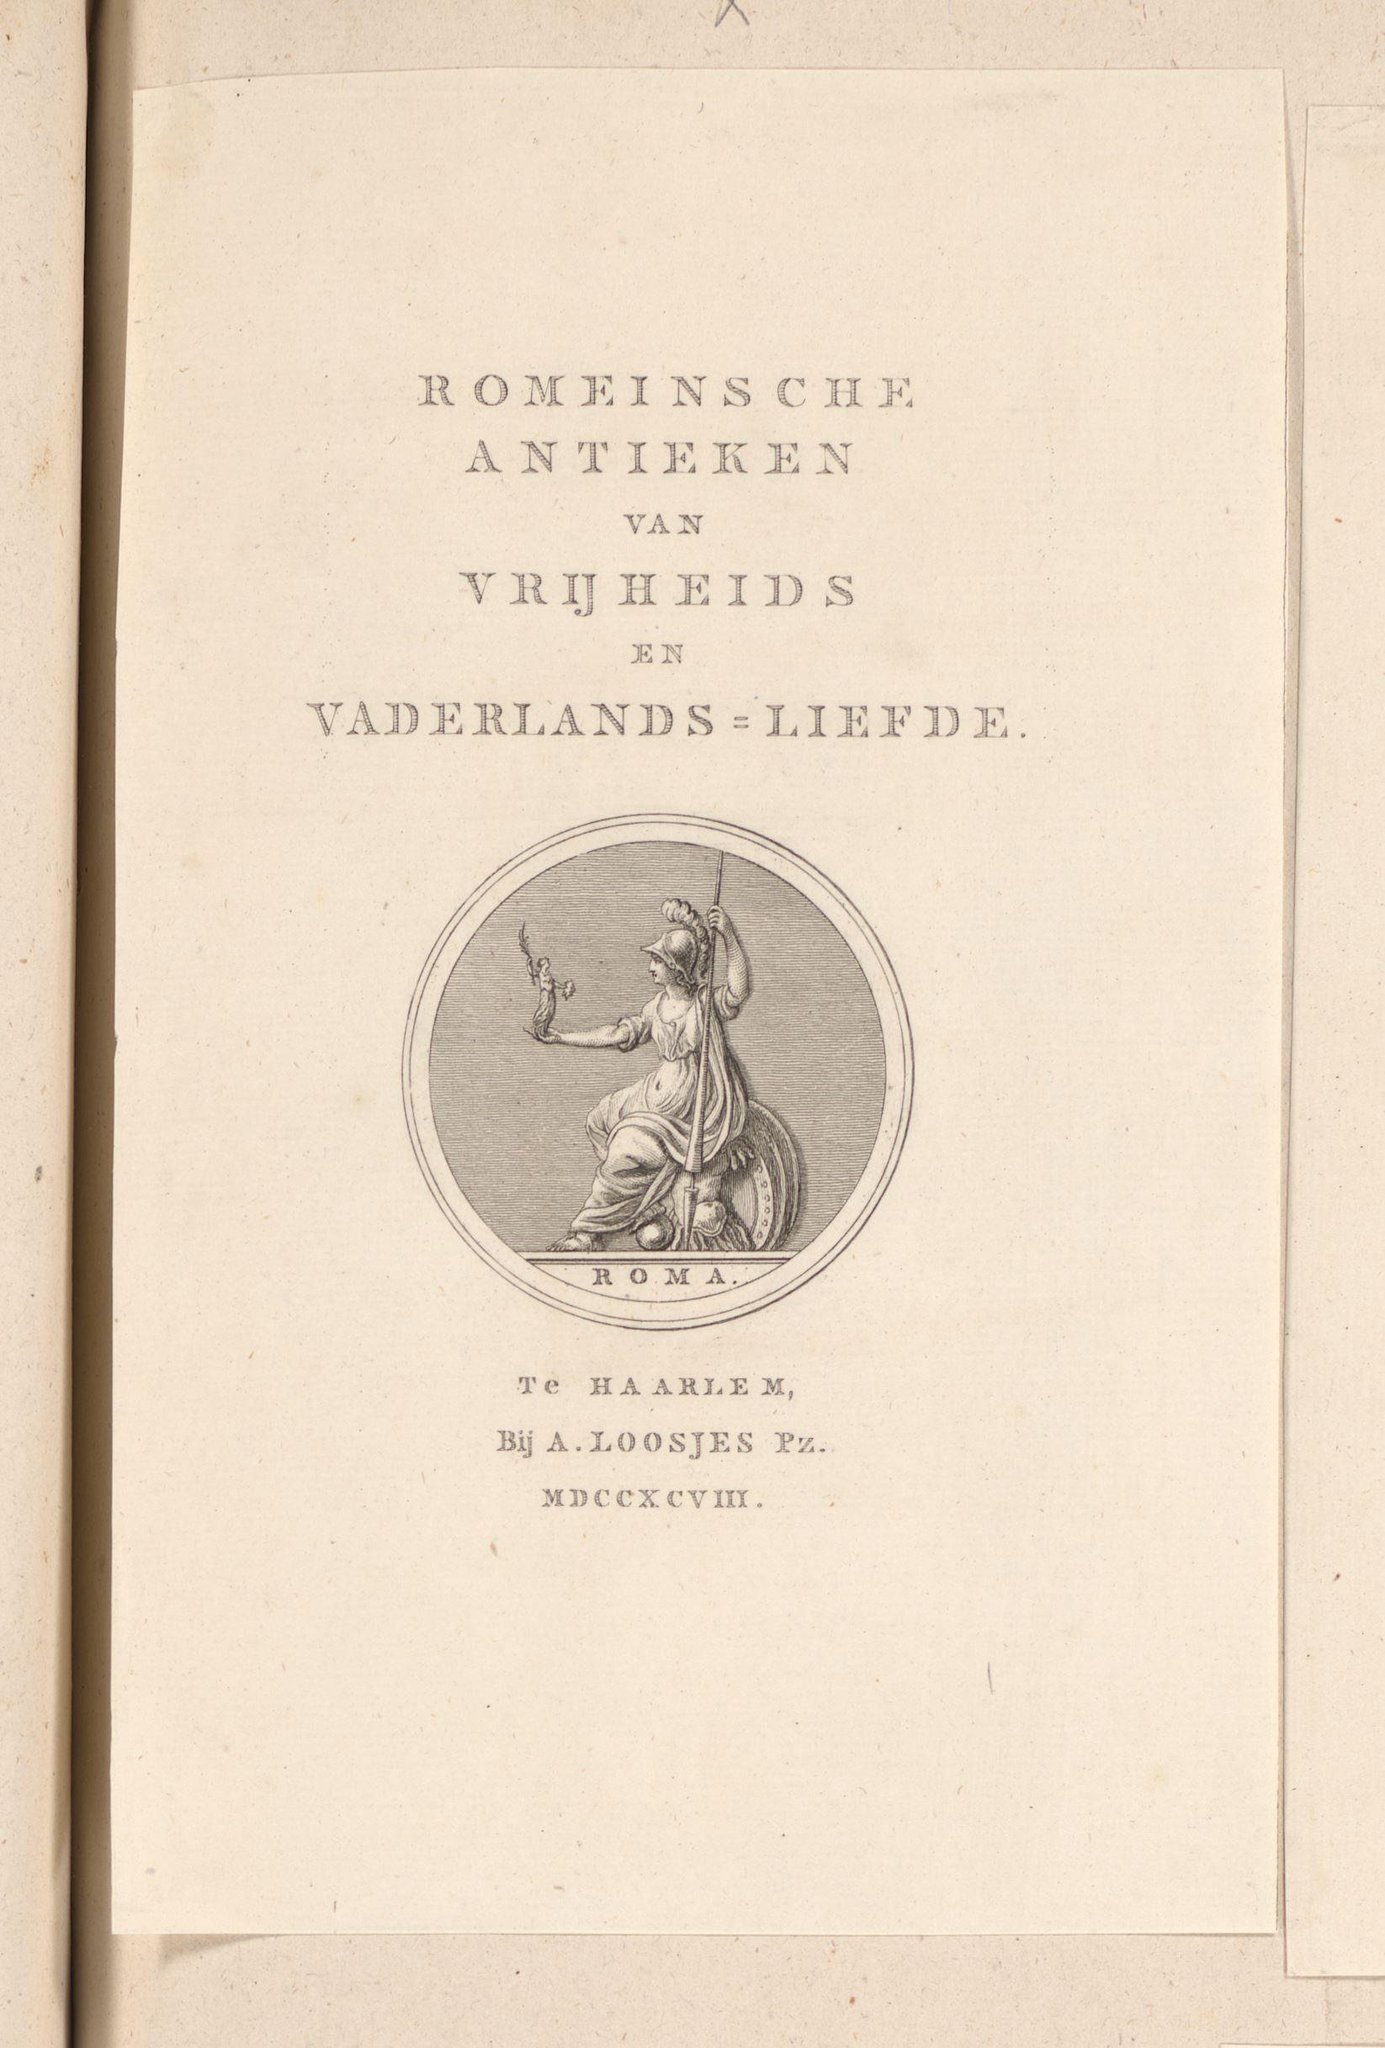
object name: print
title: Medaillon met de personificatie van de stad Rome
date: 1798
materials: paper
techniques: engraving, etching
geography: amsterdam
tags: personification of a city, town-patron(ess), rome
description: Titelpagina met een medaillon. Daarop staat de vrouwelijke personificatie van de stad Rome: een vrouw zittende op drie schilden en een harnas. Haar voet leunt op een bol. In haar linkerhand een speer. In haar rechterhand Victoria. De prent maakt deel uit van een album.